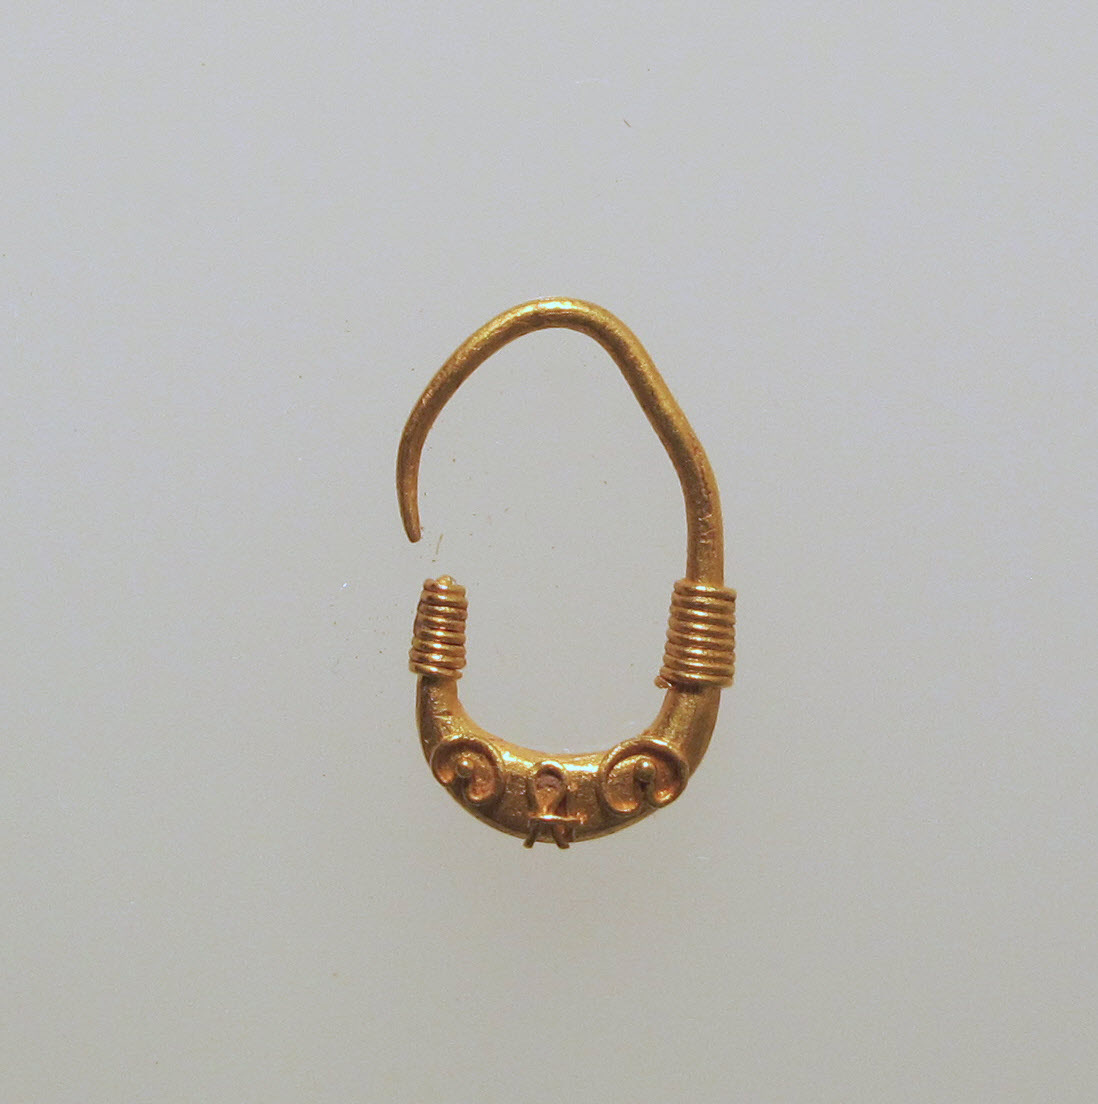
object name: earring with filigree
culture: cypriot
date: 3900 BCE-100 CE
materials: gold